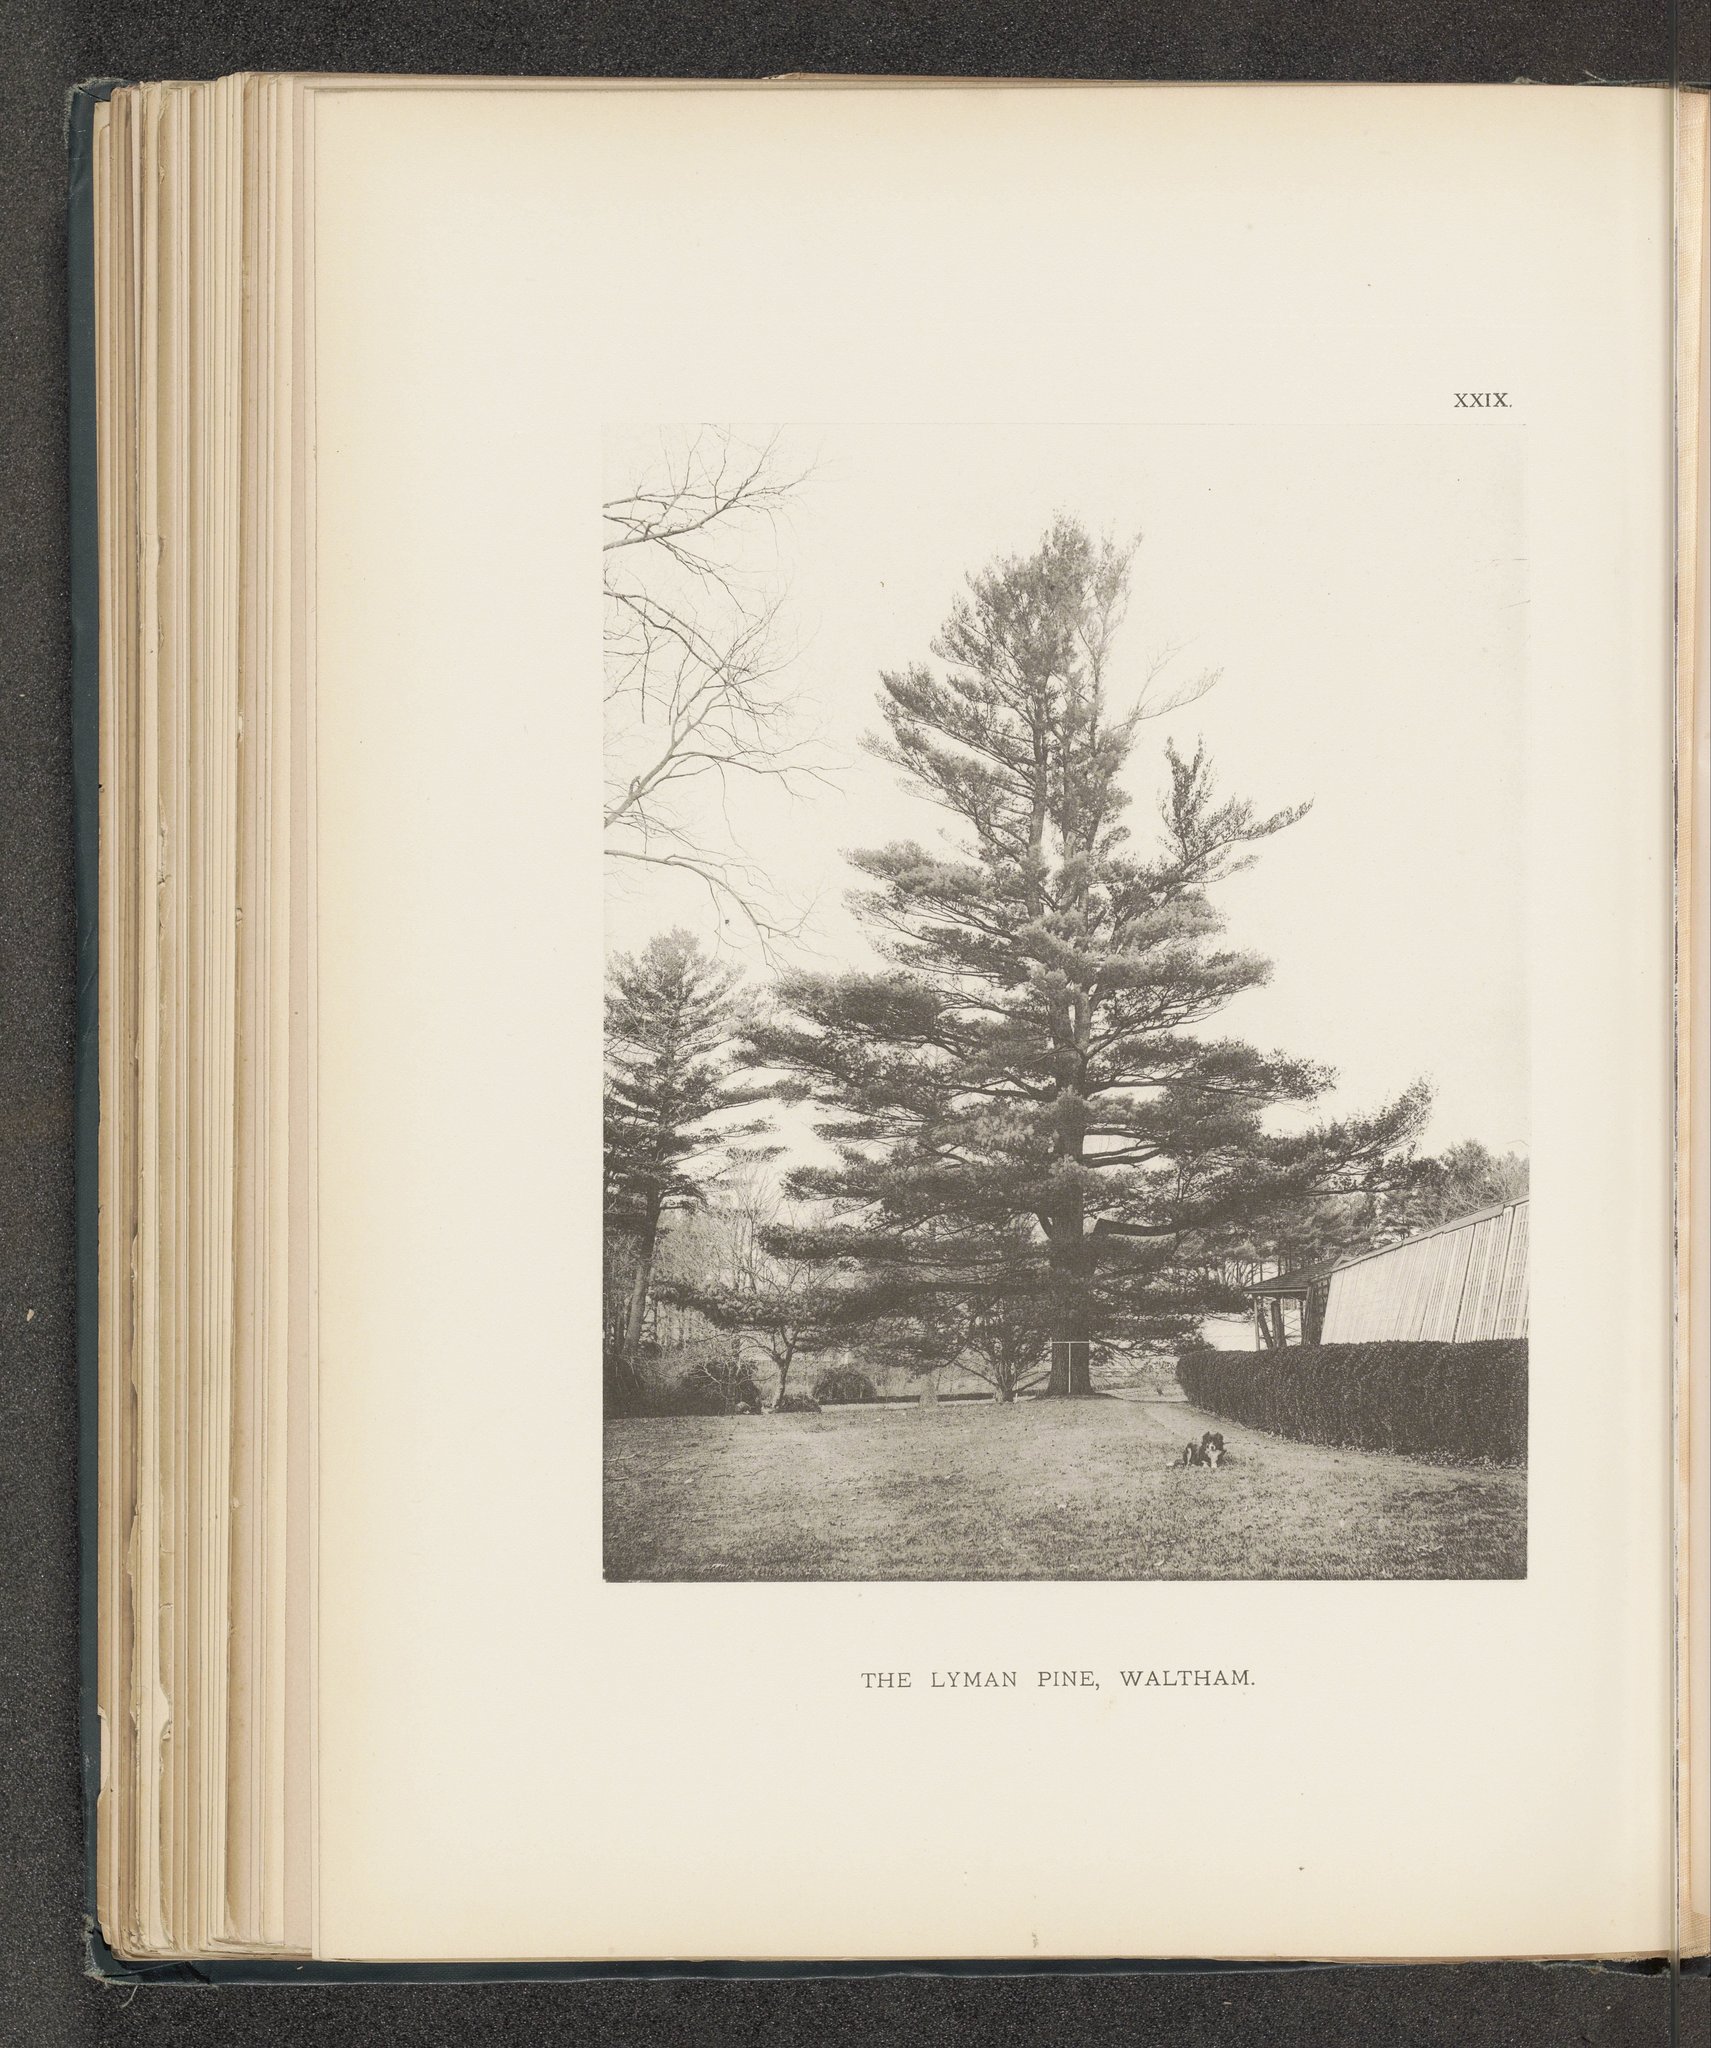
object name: page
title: The Lyman pine, Waltham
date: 1880-1890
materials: paper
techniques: photograph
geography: waltham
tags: trees: pine, backyard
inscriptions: number: ‘XXIX.’